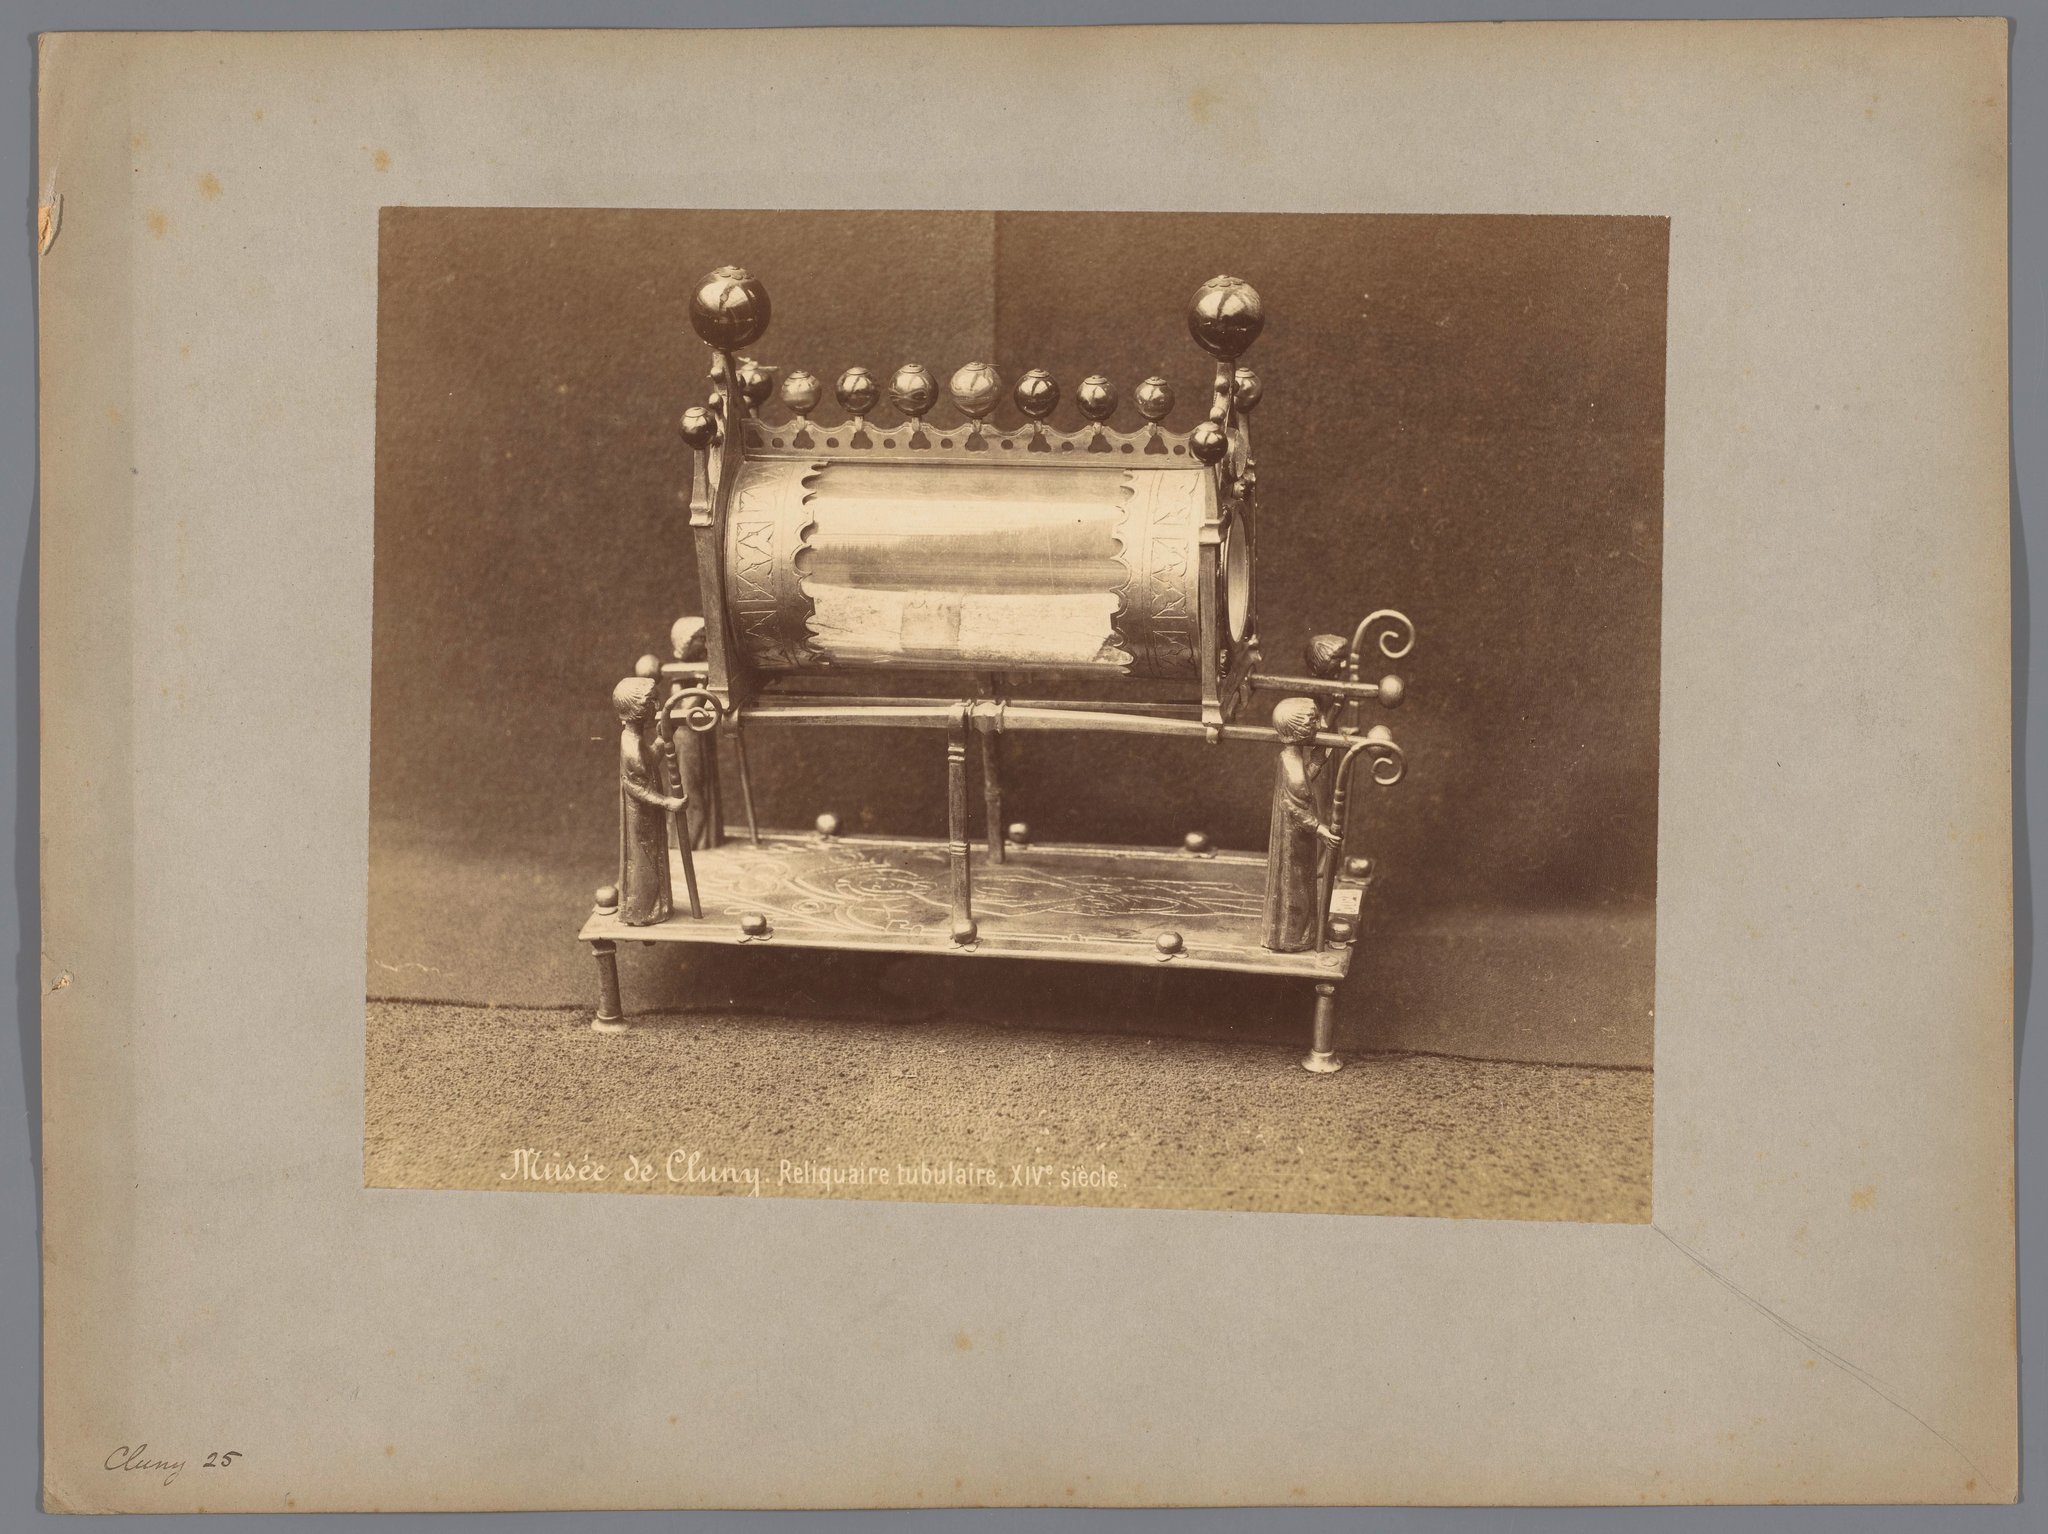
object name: photograph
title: Reliquaire tubulaire, XIVe siècle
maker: séraphin-médéric mieusement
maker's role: fotograaf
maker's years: 1840-1905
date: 1850-1900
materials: cardboard, photographic support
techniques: albumen print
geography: paris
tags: relics (and reliquaries)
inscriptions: number: ‘Cluny 25’, collector's mark: ‘Rijks-normaalschool voor teekenonderwijzers Amsterdam’ Lugt 3937, workshop stamp: ‘Mieusement/ Photographe’